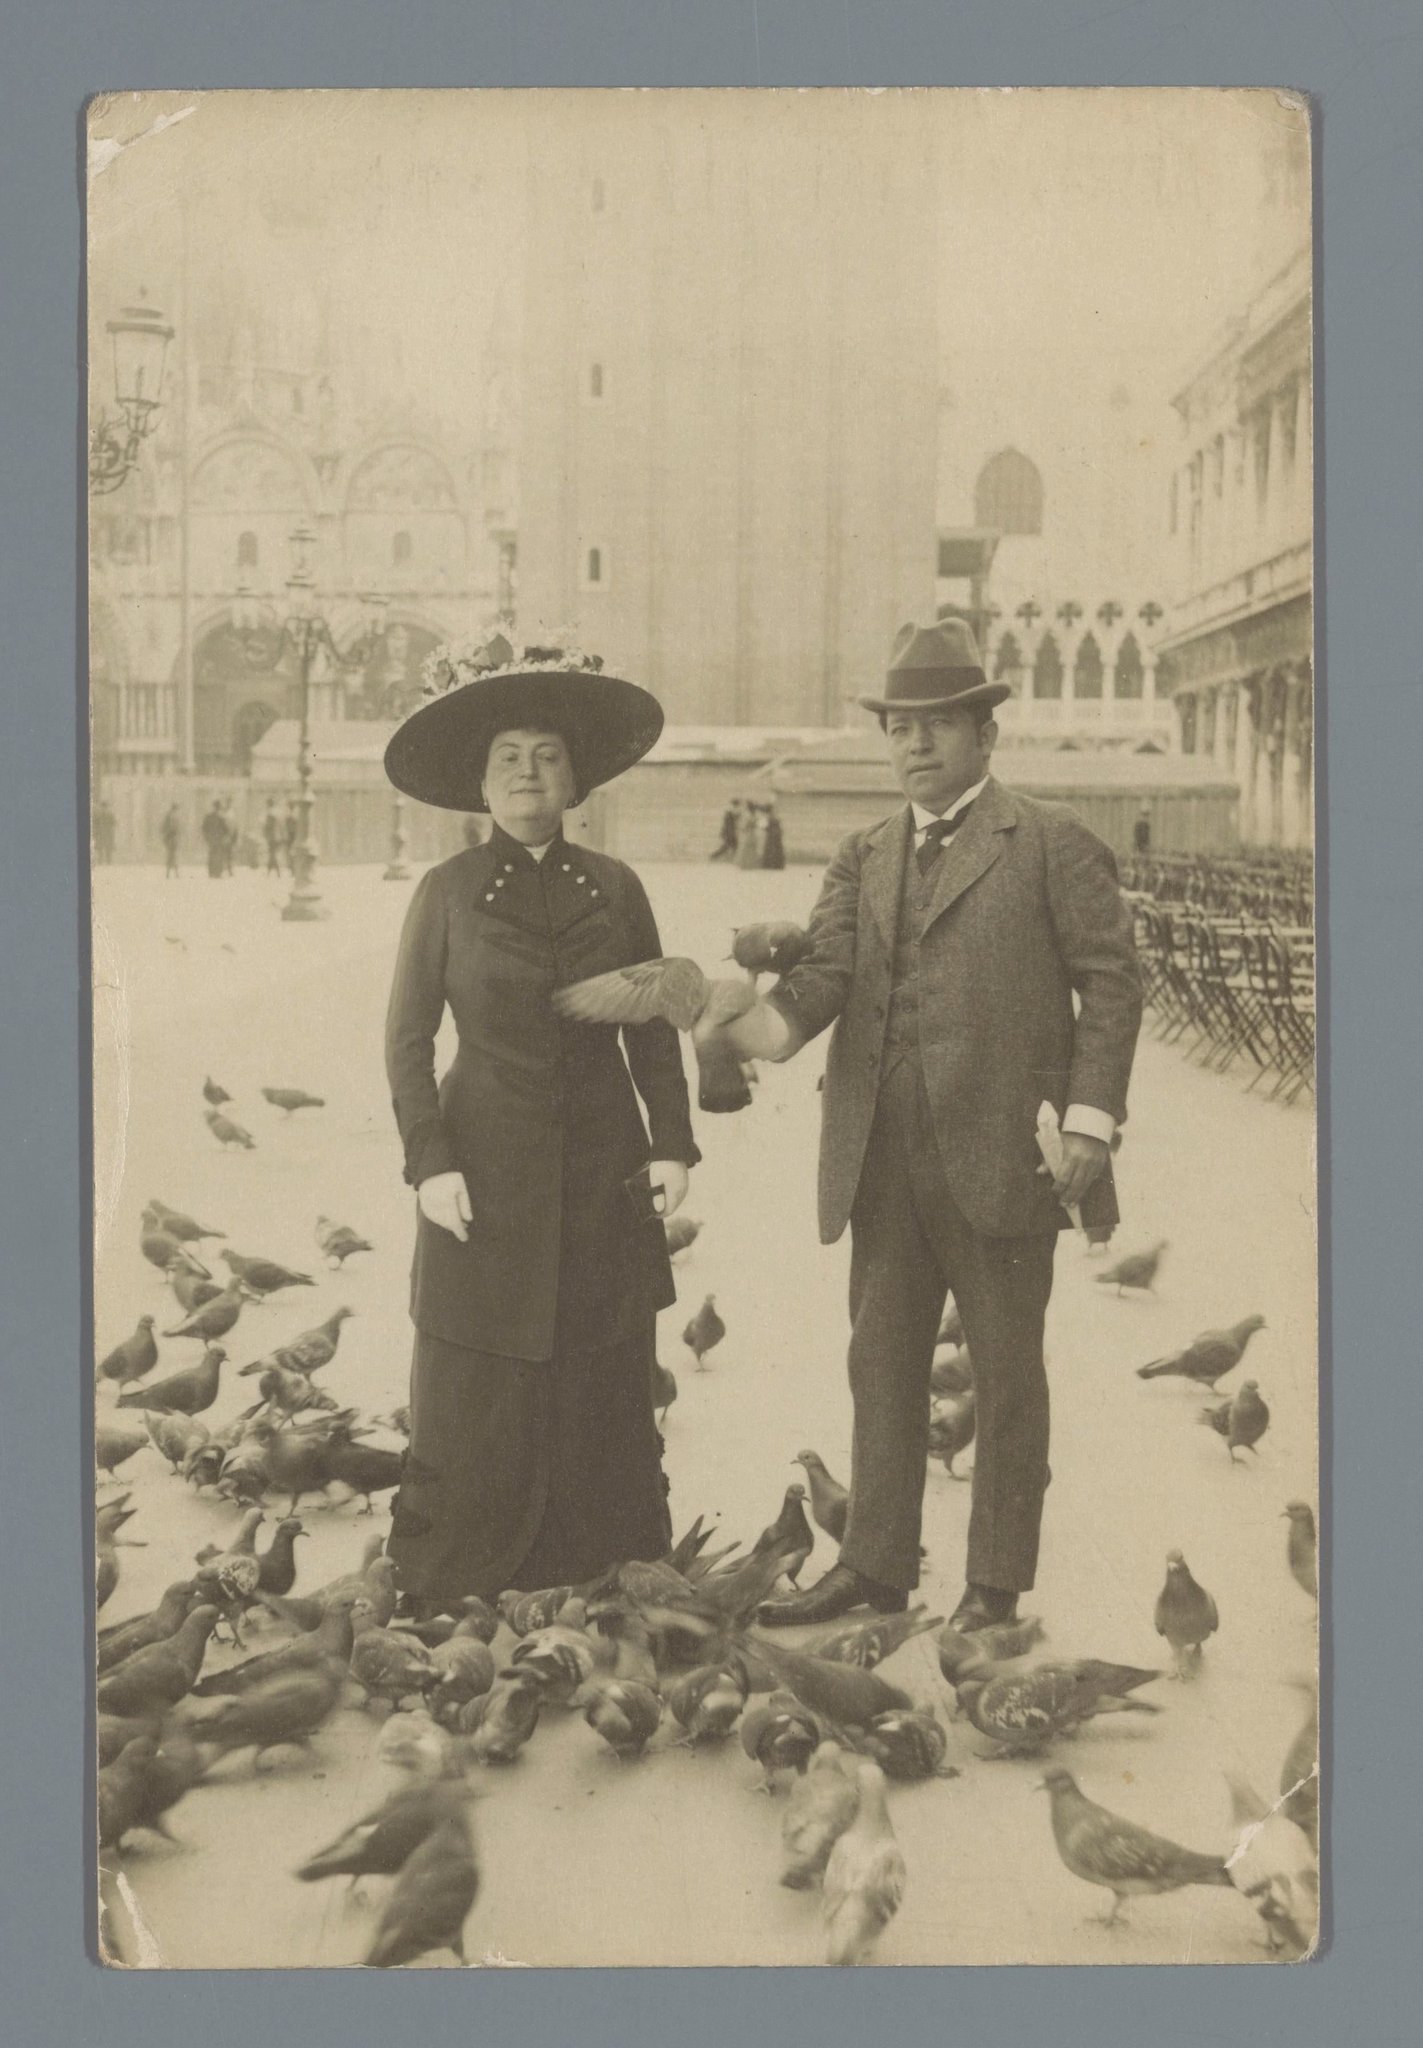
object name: ansichtkaart, prentbriefkaart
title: Portret van een onbekende man en vrouw met duiven op het San Marcoplein te Venetië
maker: g. lorigiola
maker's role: fotograaf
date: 1910-1920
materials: photographic support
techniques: gelatin silver print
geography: san marco square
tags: square, place, circus, etc., marriage, married couple, 'matrimonium', feeding wild animals, doves, pigeons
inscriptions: inscription: ‘Lorigiola, G., Fotografo, S. Marco 560 - Venezia’, inscription: ‘Meme (...) Maxi’